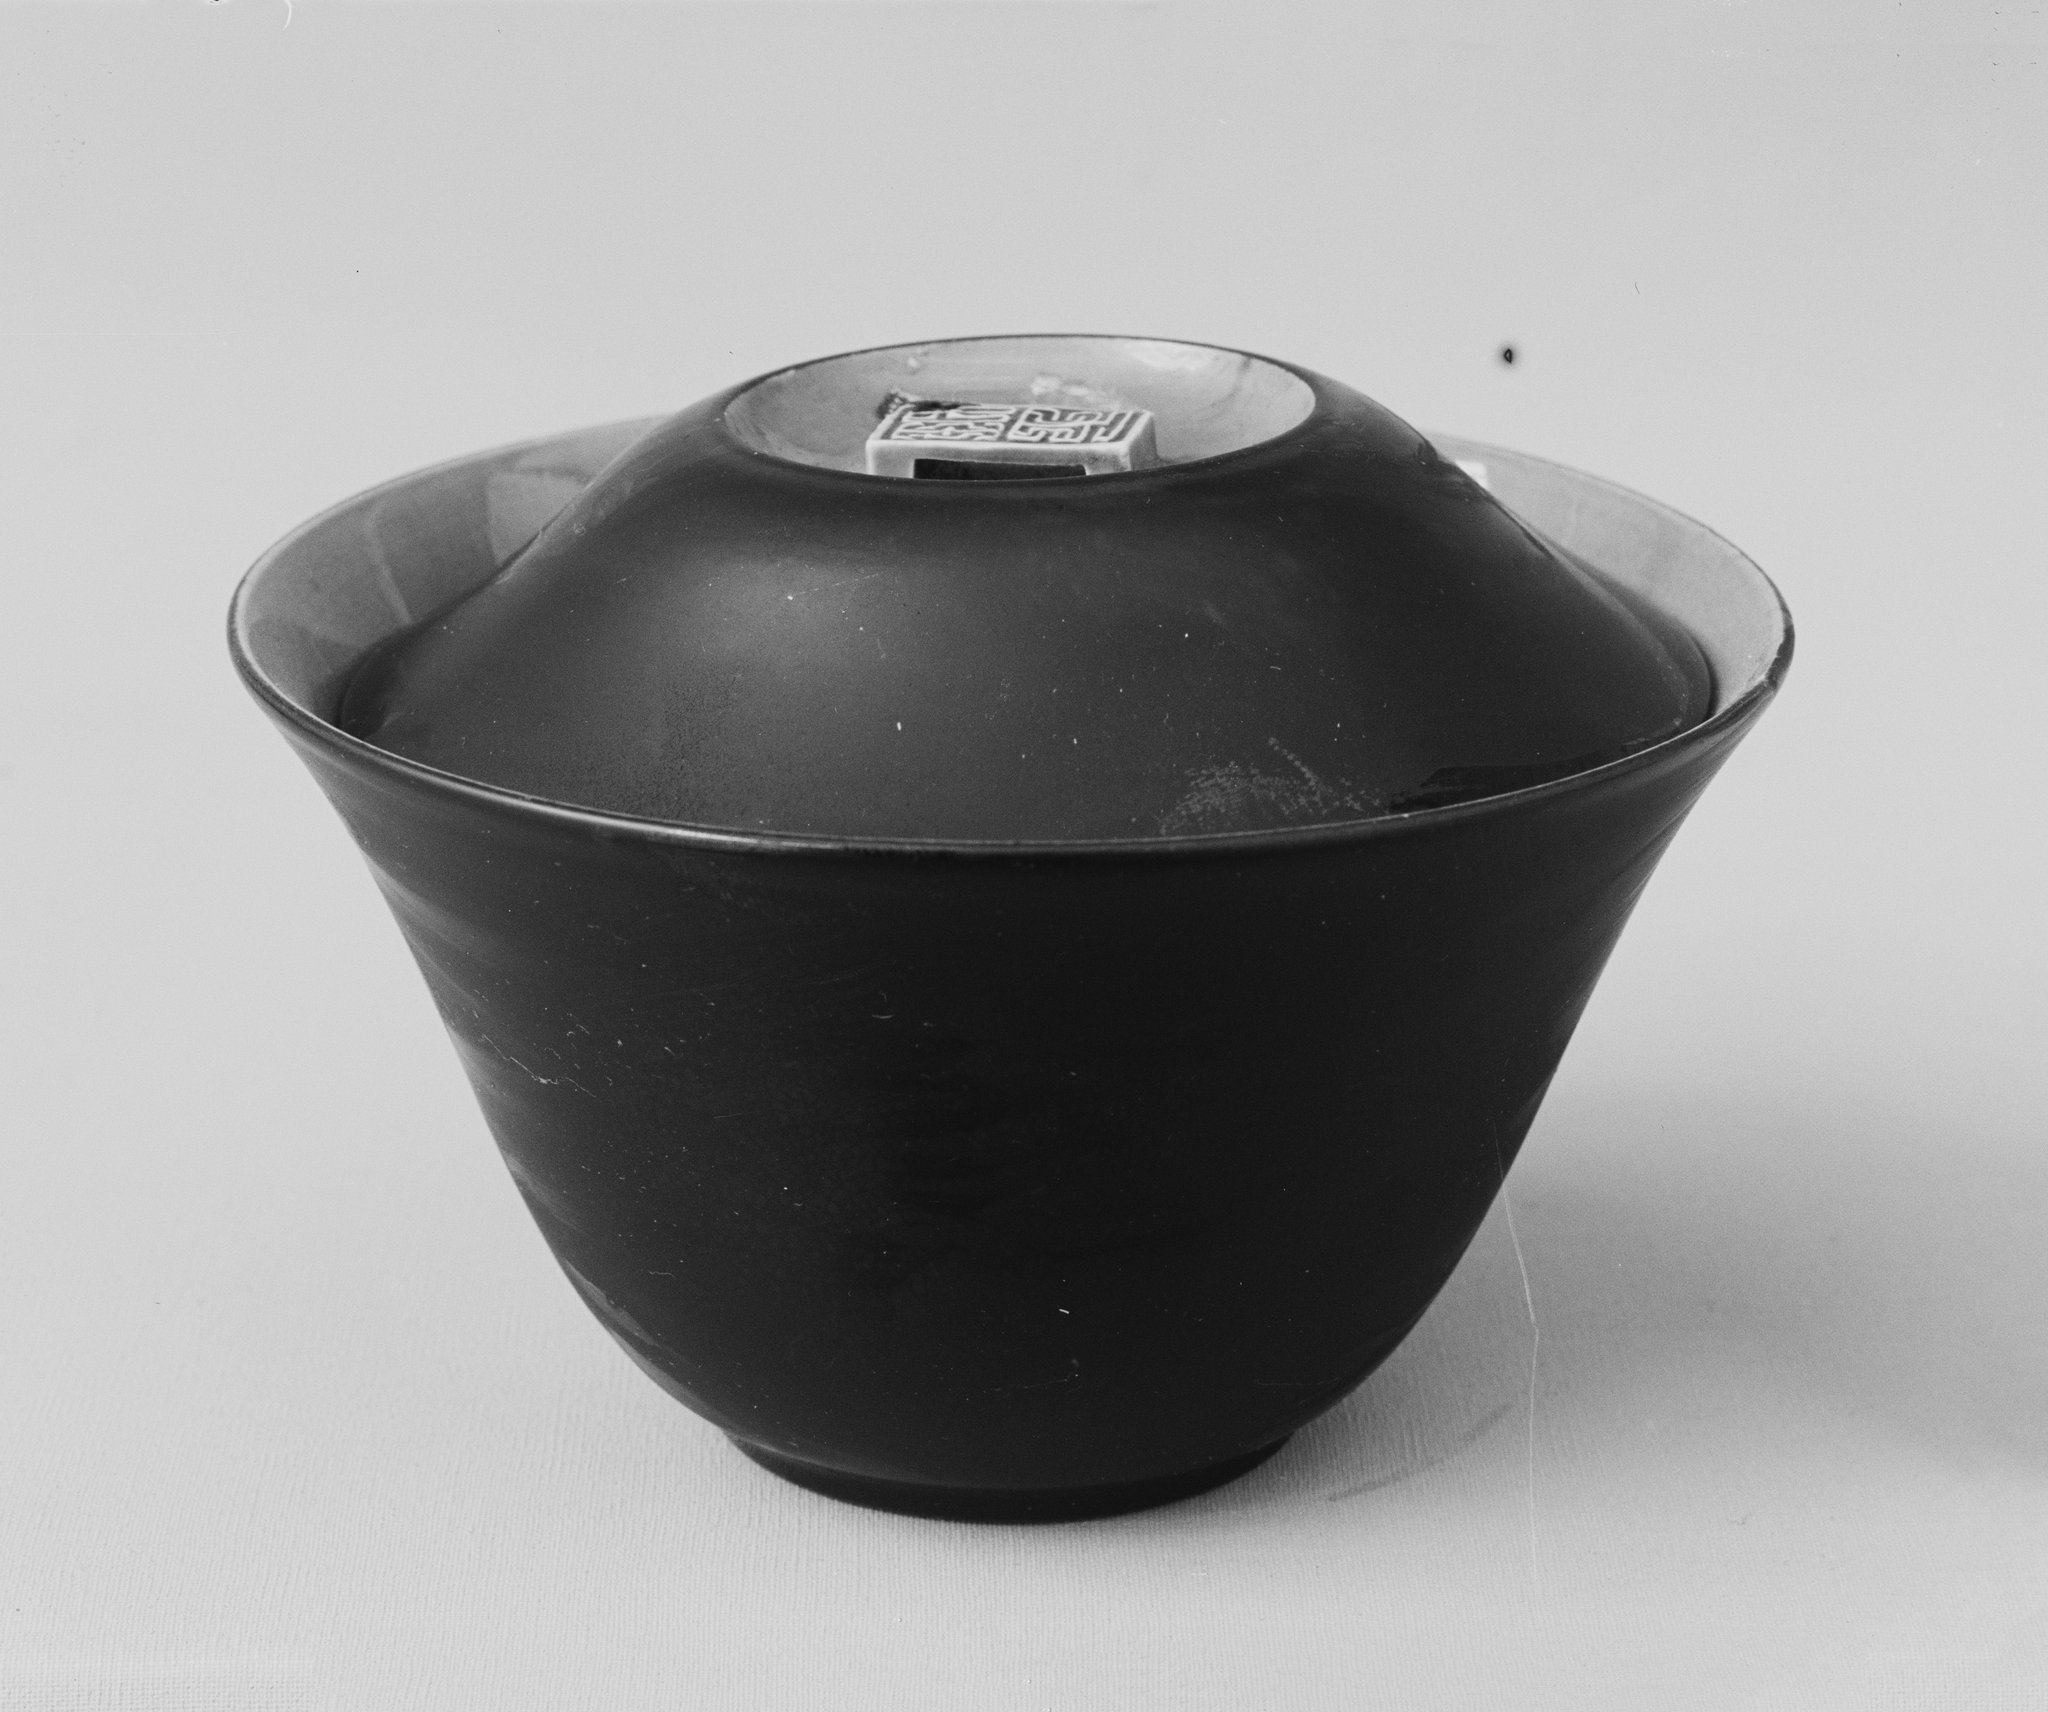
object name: bowl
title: Bowl and Cover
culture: japanese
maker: minpei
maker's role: artist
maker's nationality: japanese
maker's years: 19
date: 1840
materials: glaze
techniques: enamel